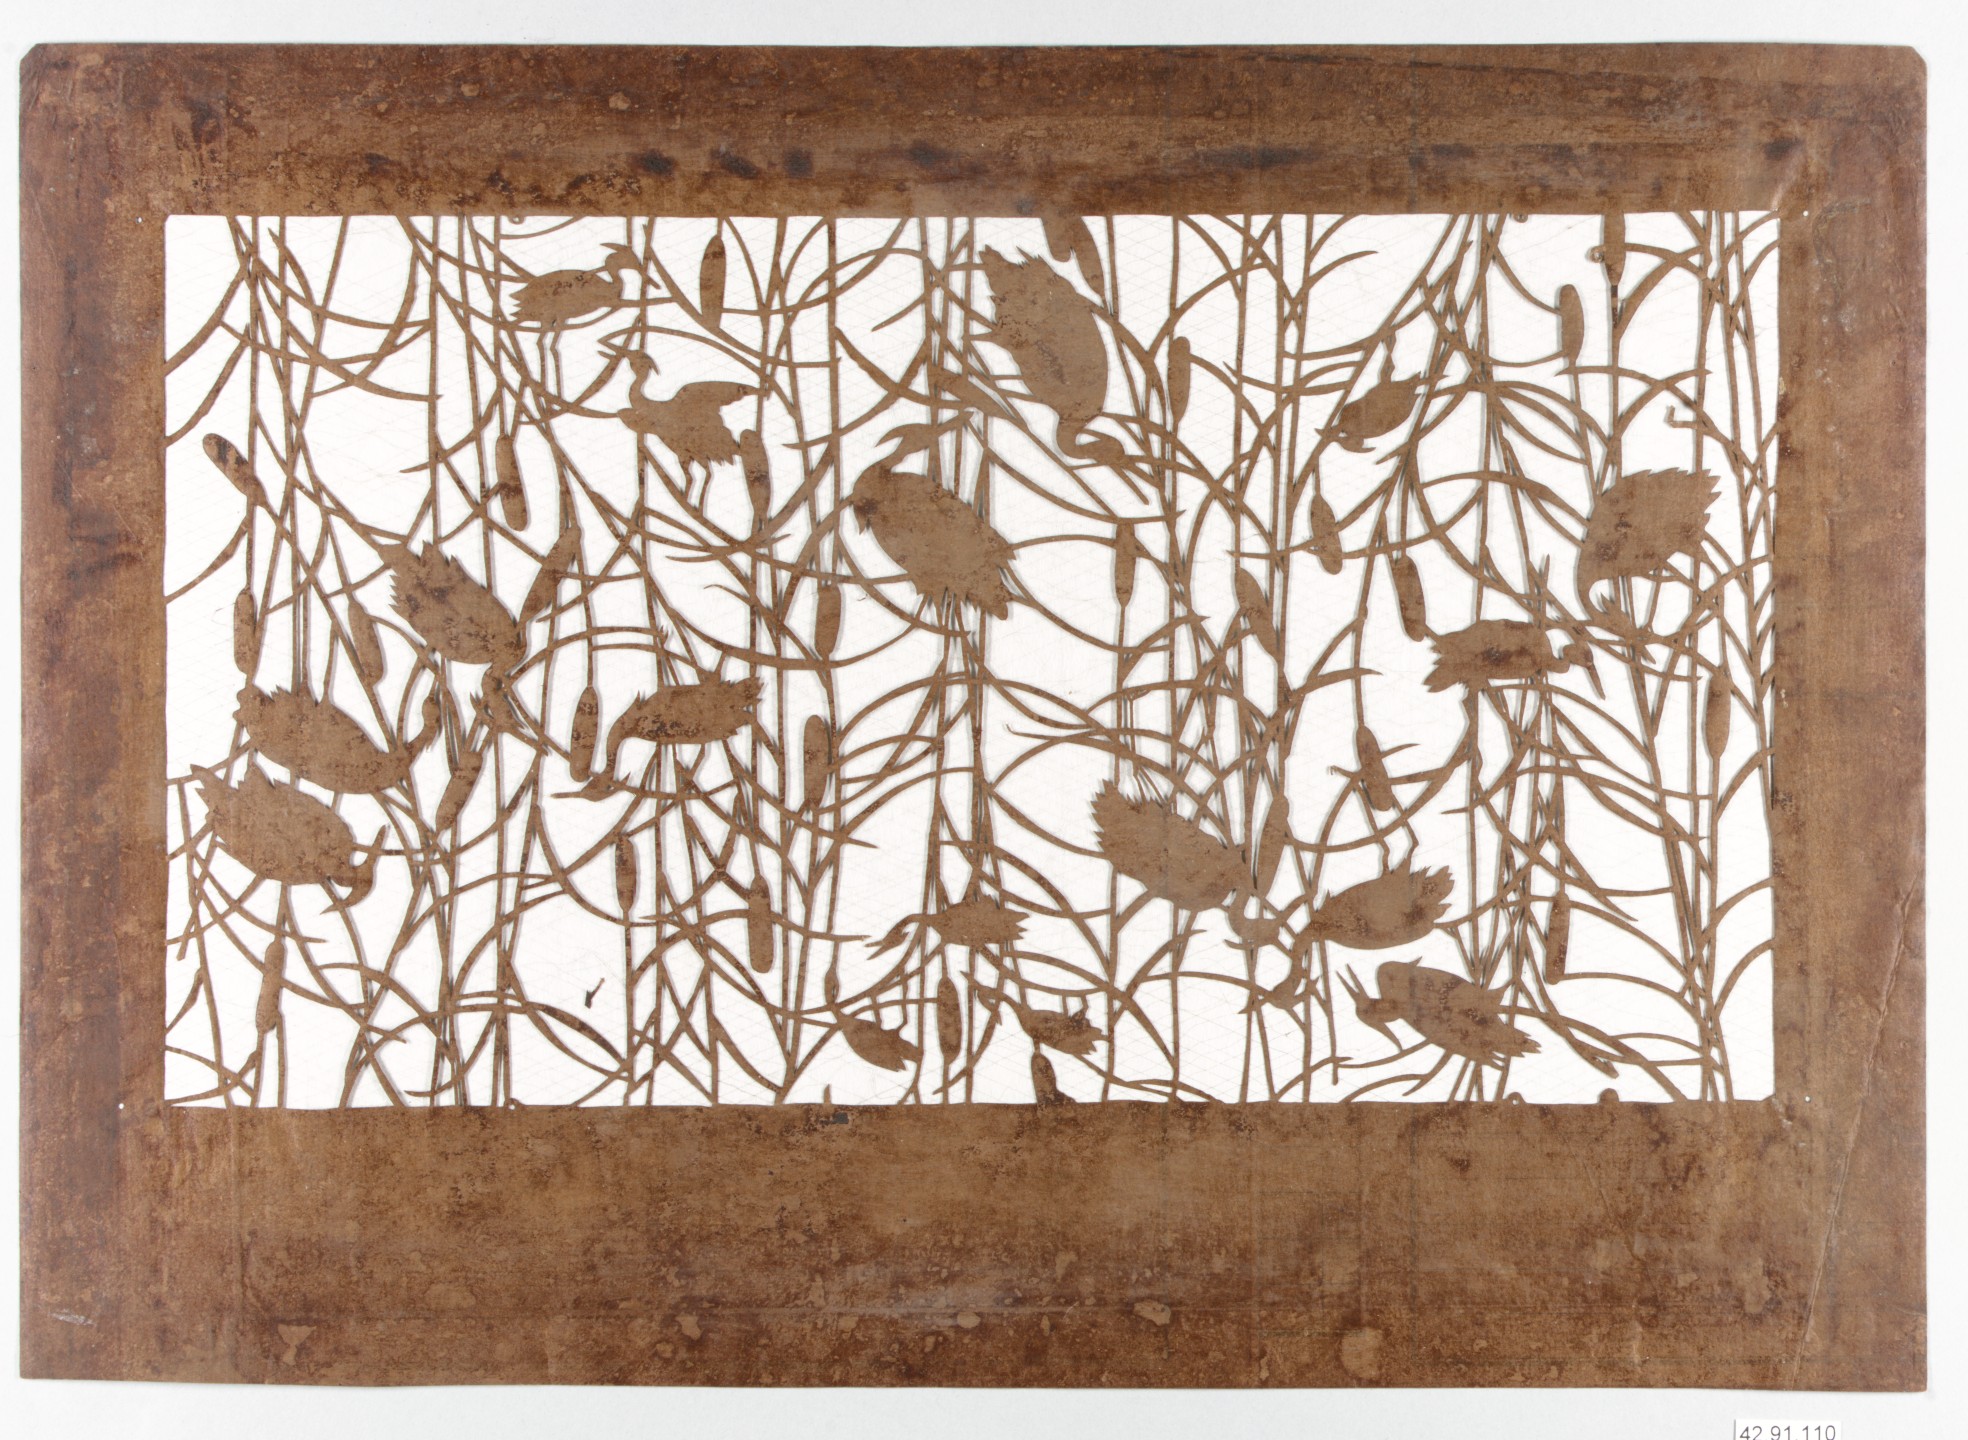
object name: stencil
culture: japanese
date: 1801-1900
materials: paper, silk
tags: birds